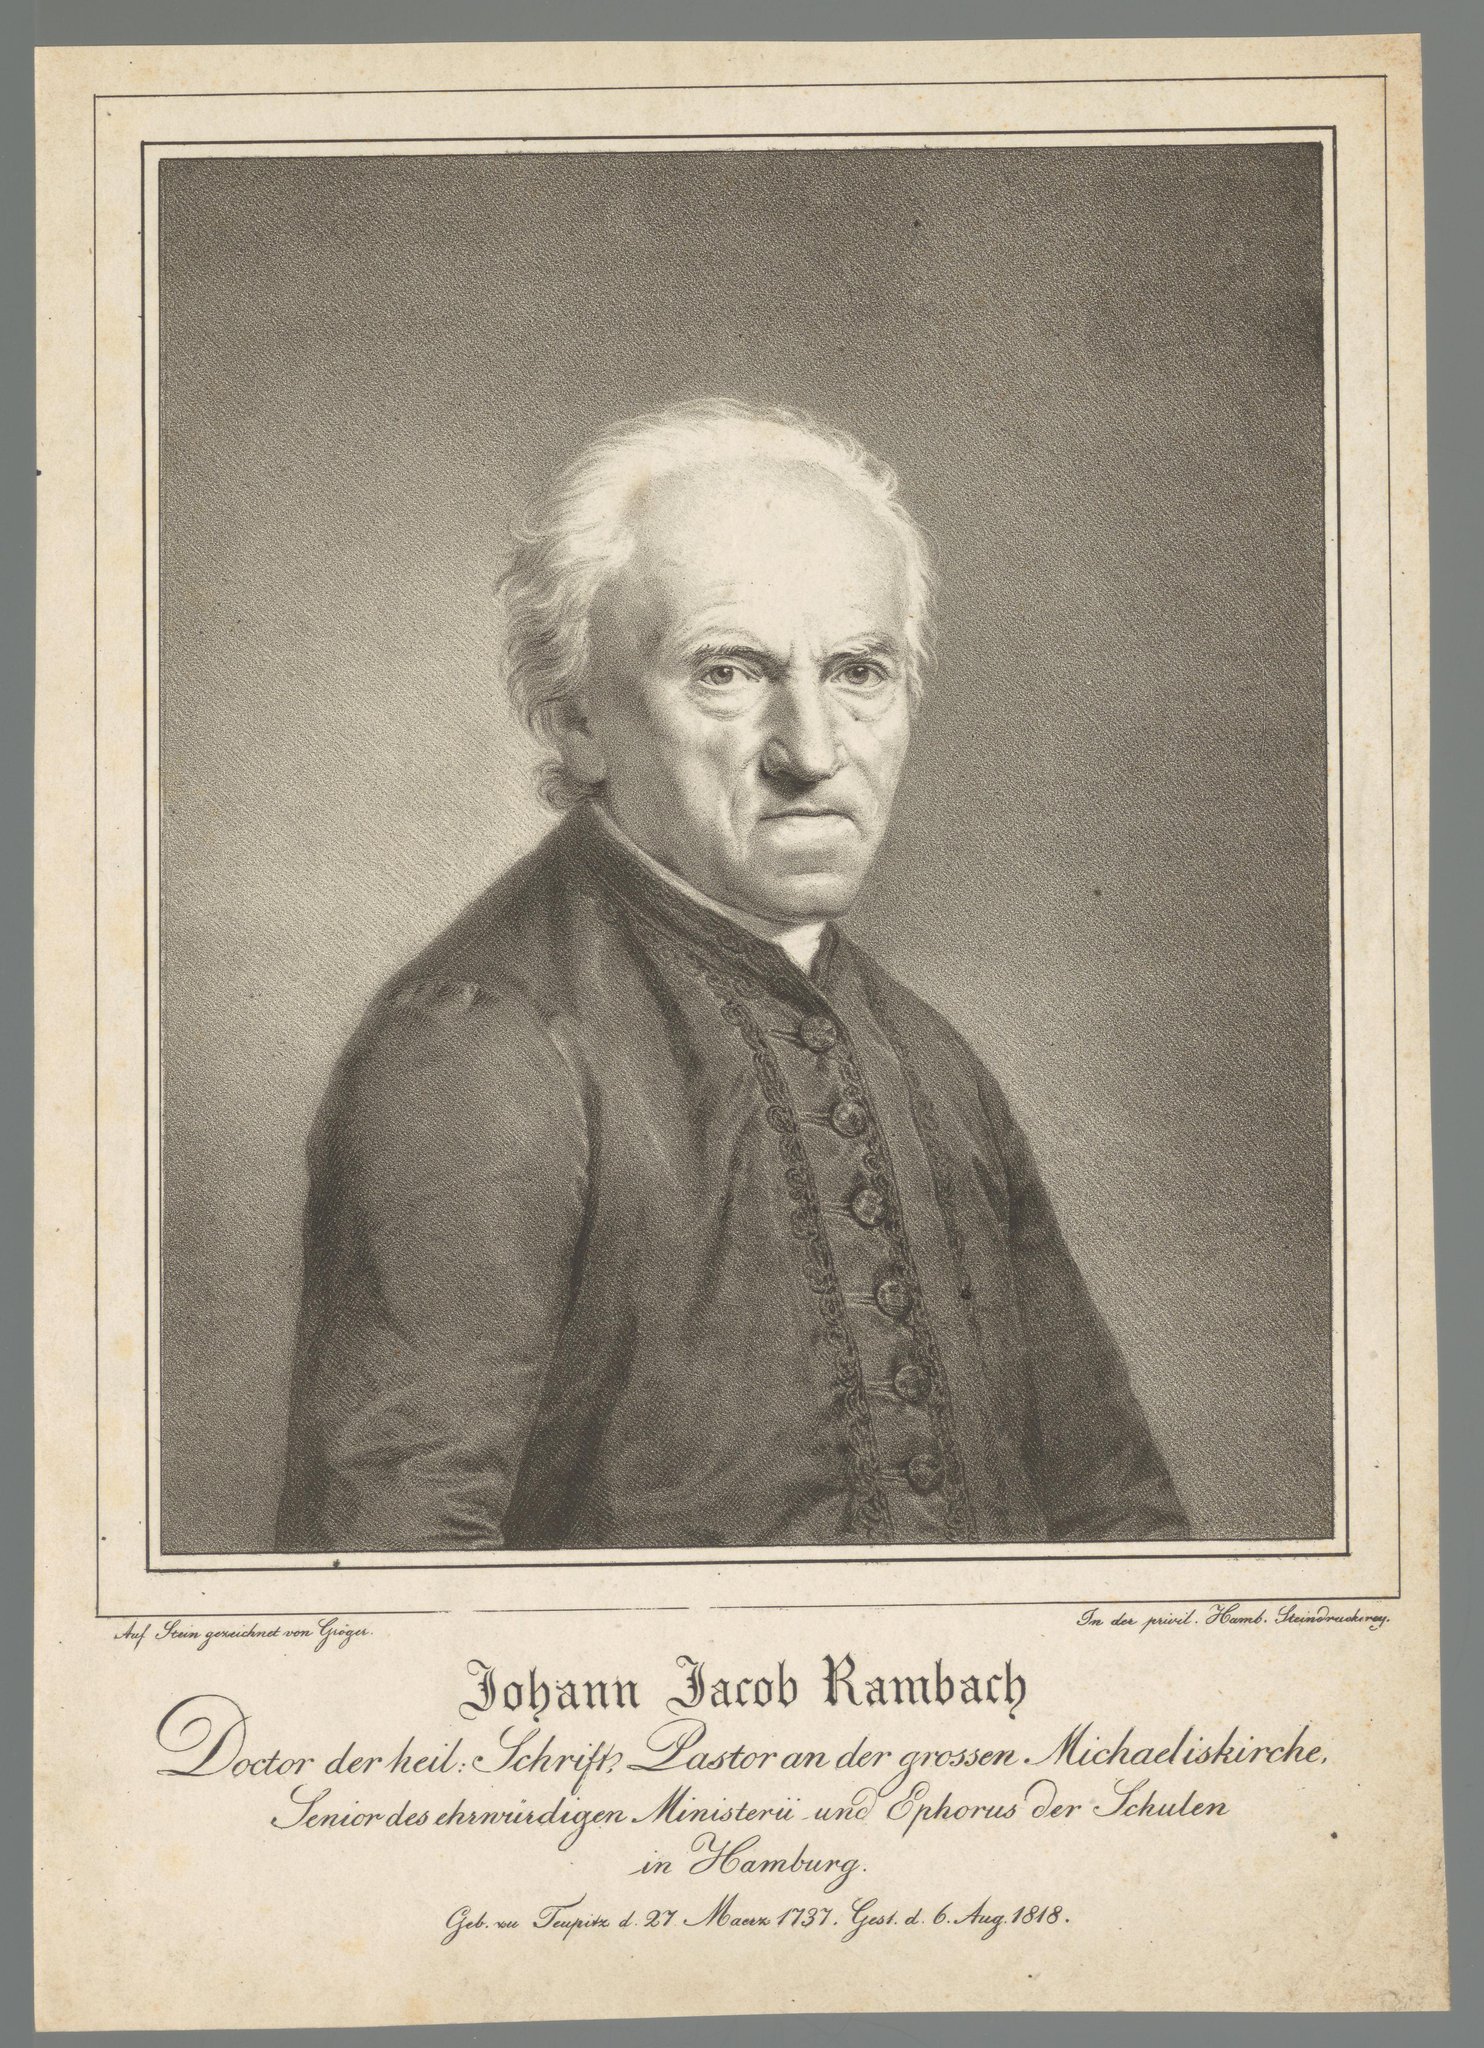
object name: print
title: Portret van Johann Jakob Rambach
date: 1818-1838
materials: paper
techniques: lithograph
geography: hamburg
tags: adult man, historical persons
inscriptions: collector's mark: Lugt 2228